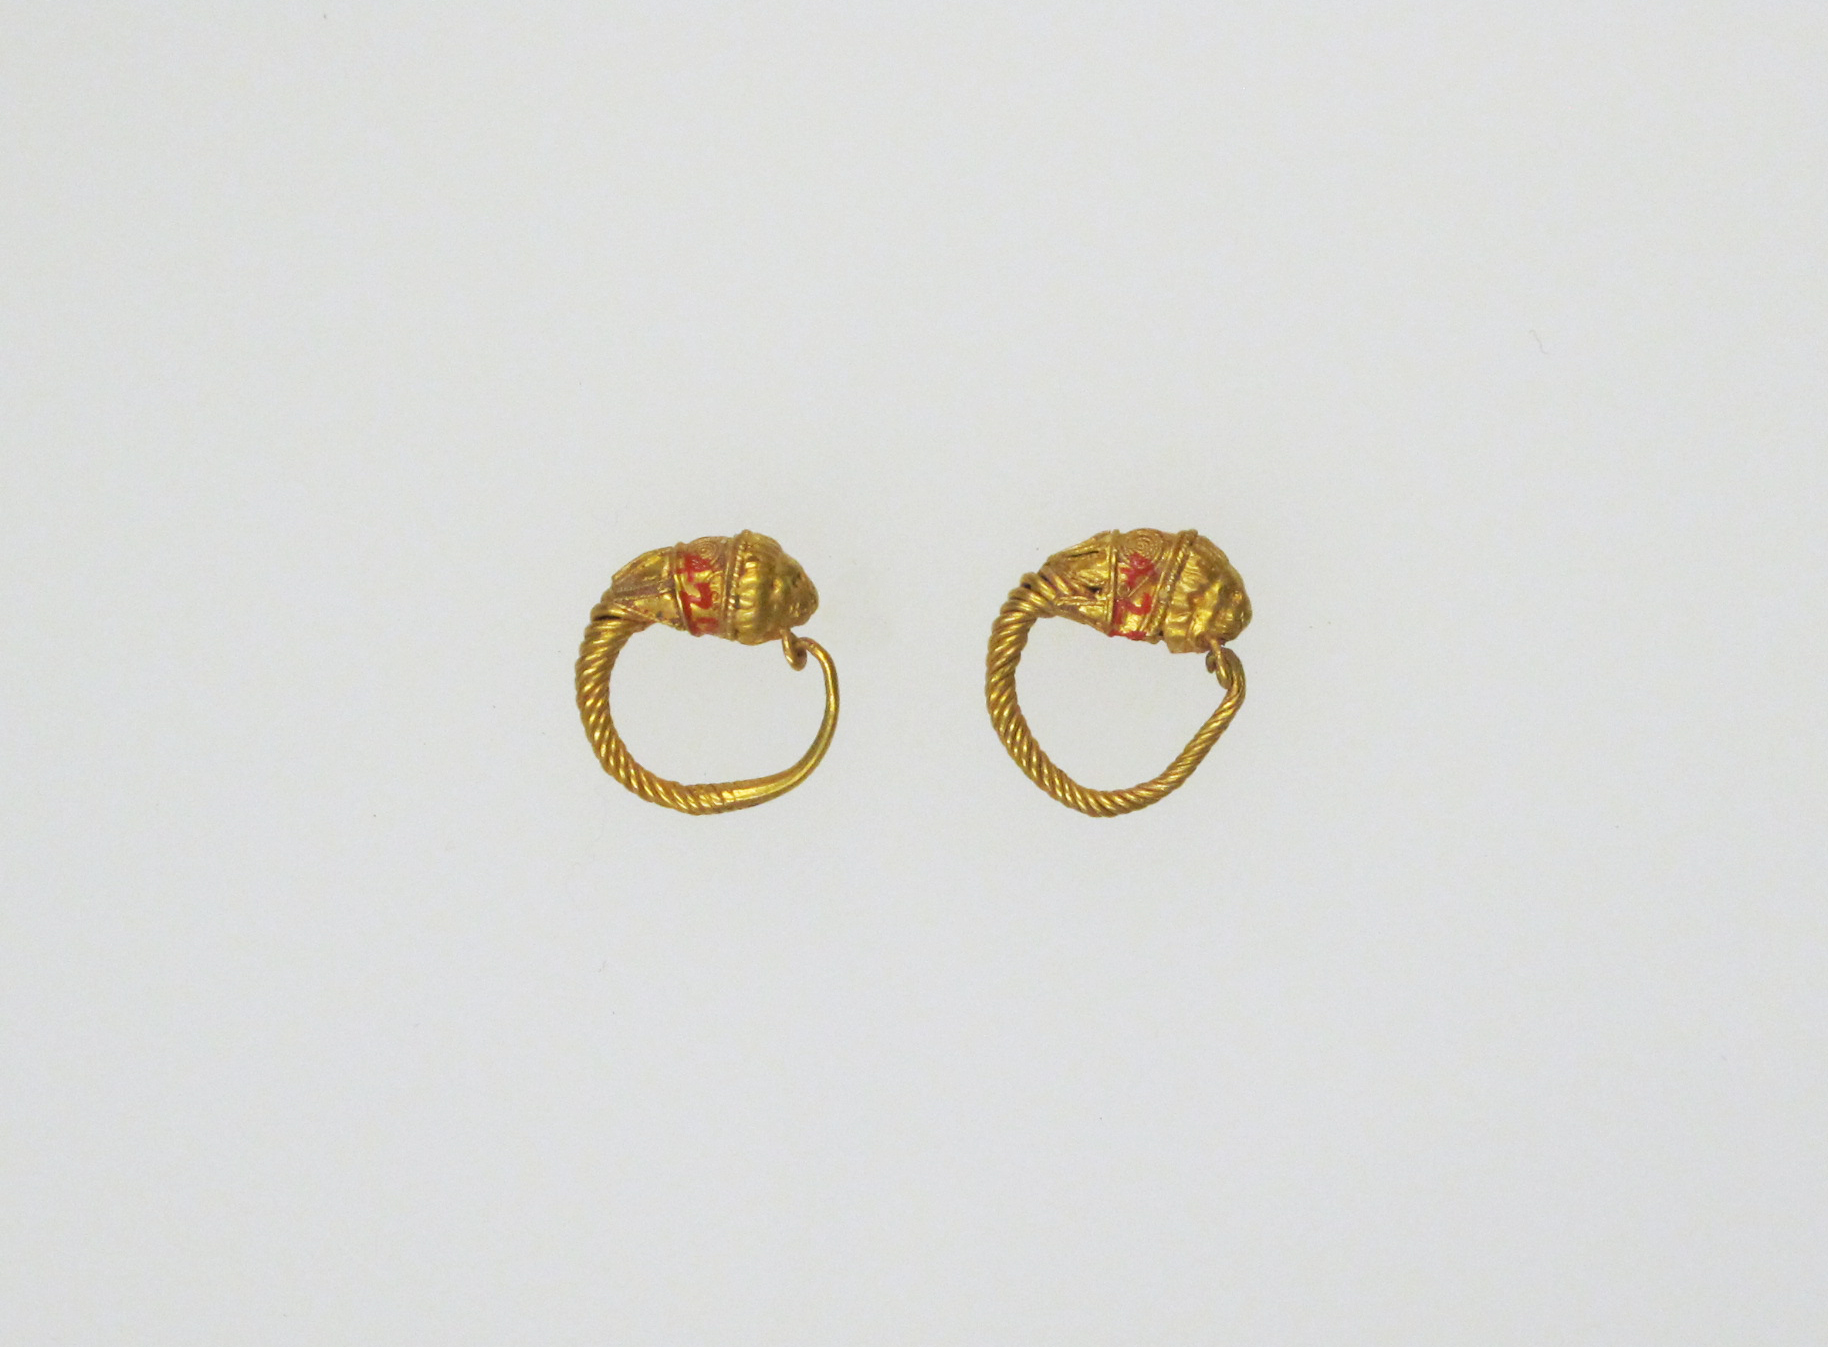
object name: earring with head of lion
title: Earring with head of lions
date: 7000 BCE-330 CE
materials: gold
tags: lions